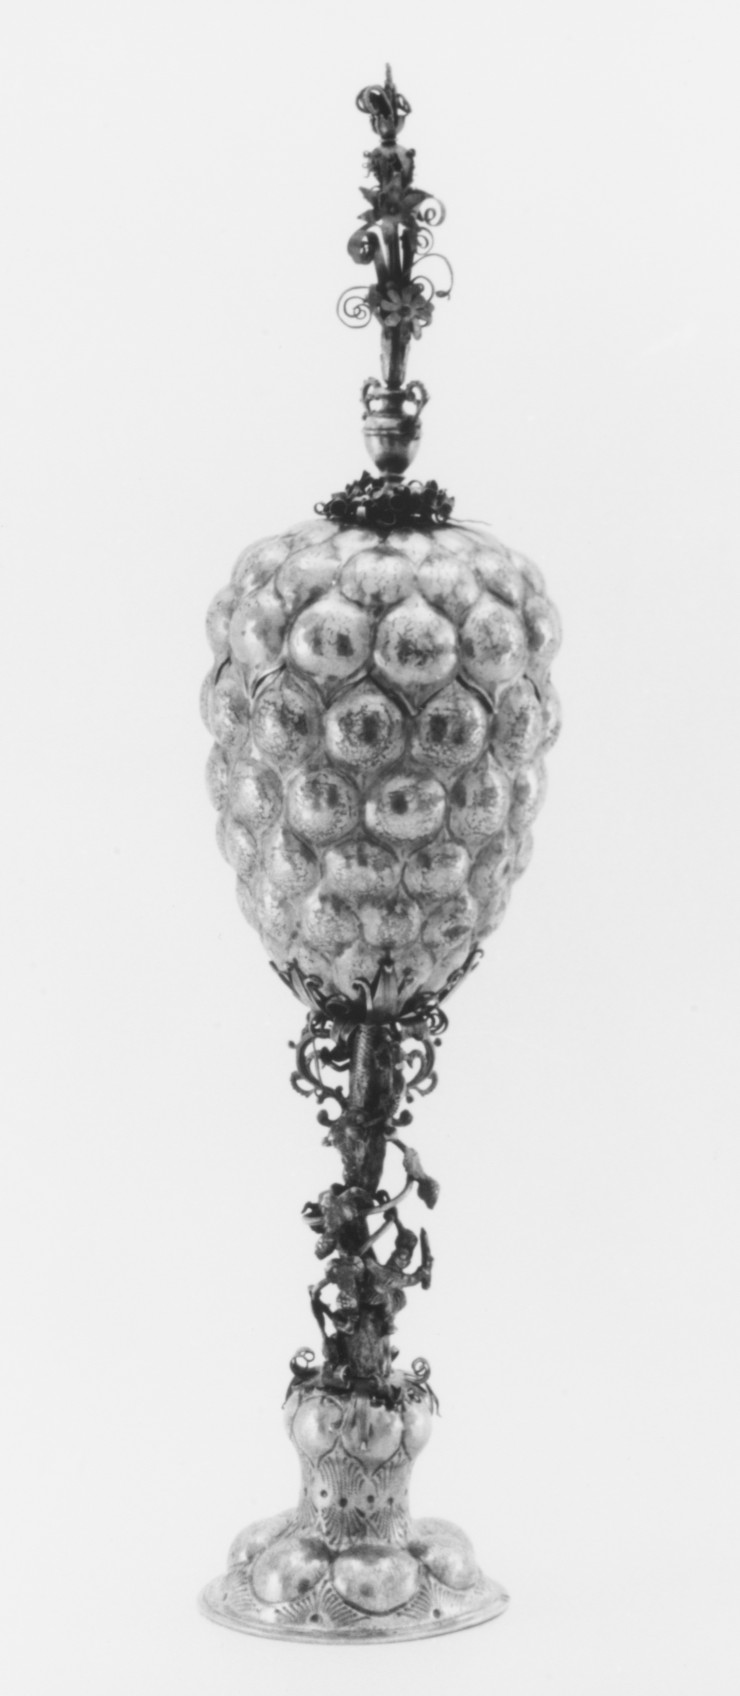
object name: pineapple cup with cover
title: Pineapple cup with cover (Hanap)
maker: caspar beutmüller the younger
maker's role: maker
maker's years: 1612-1632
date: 1601-1700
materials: gilt, silver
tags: fruit